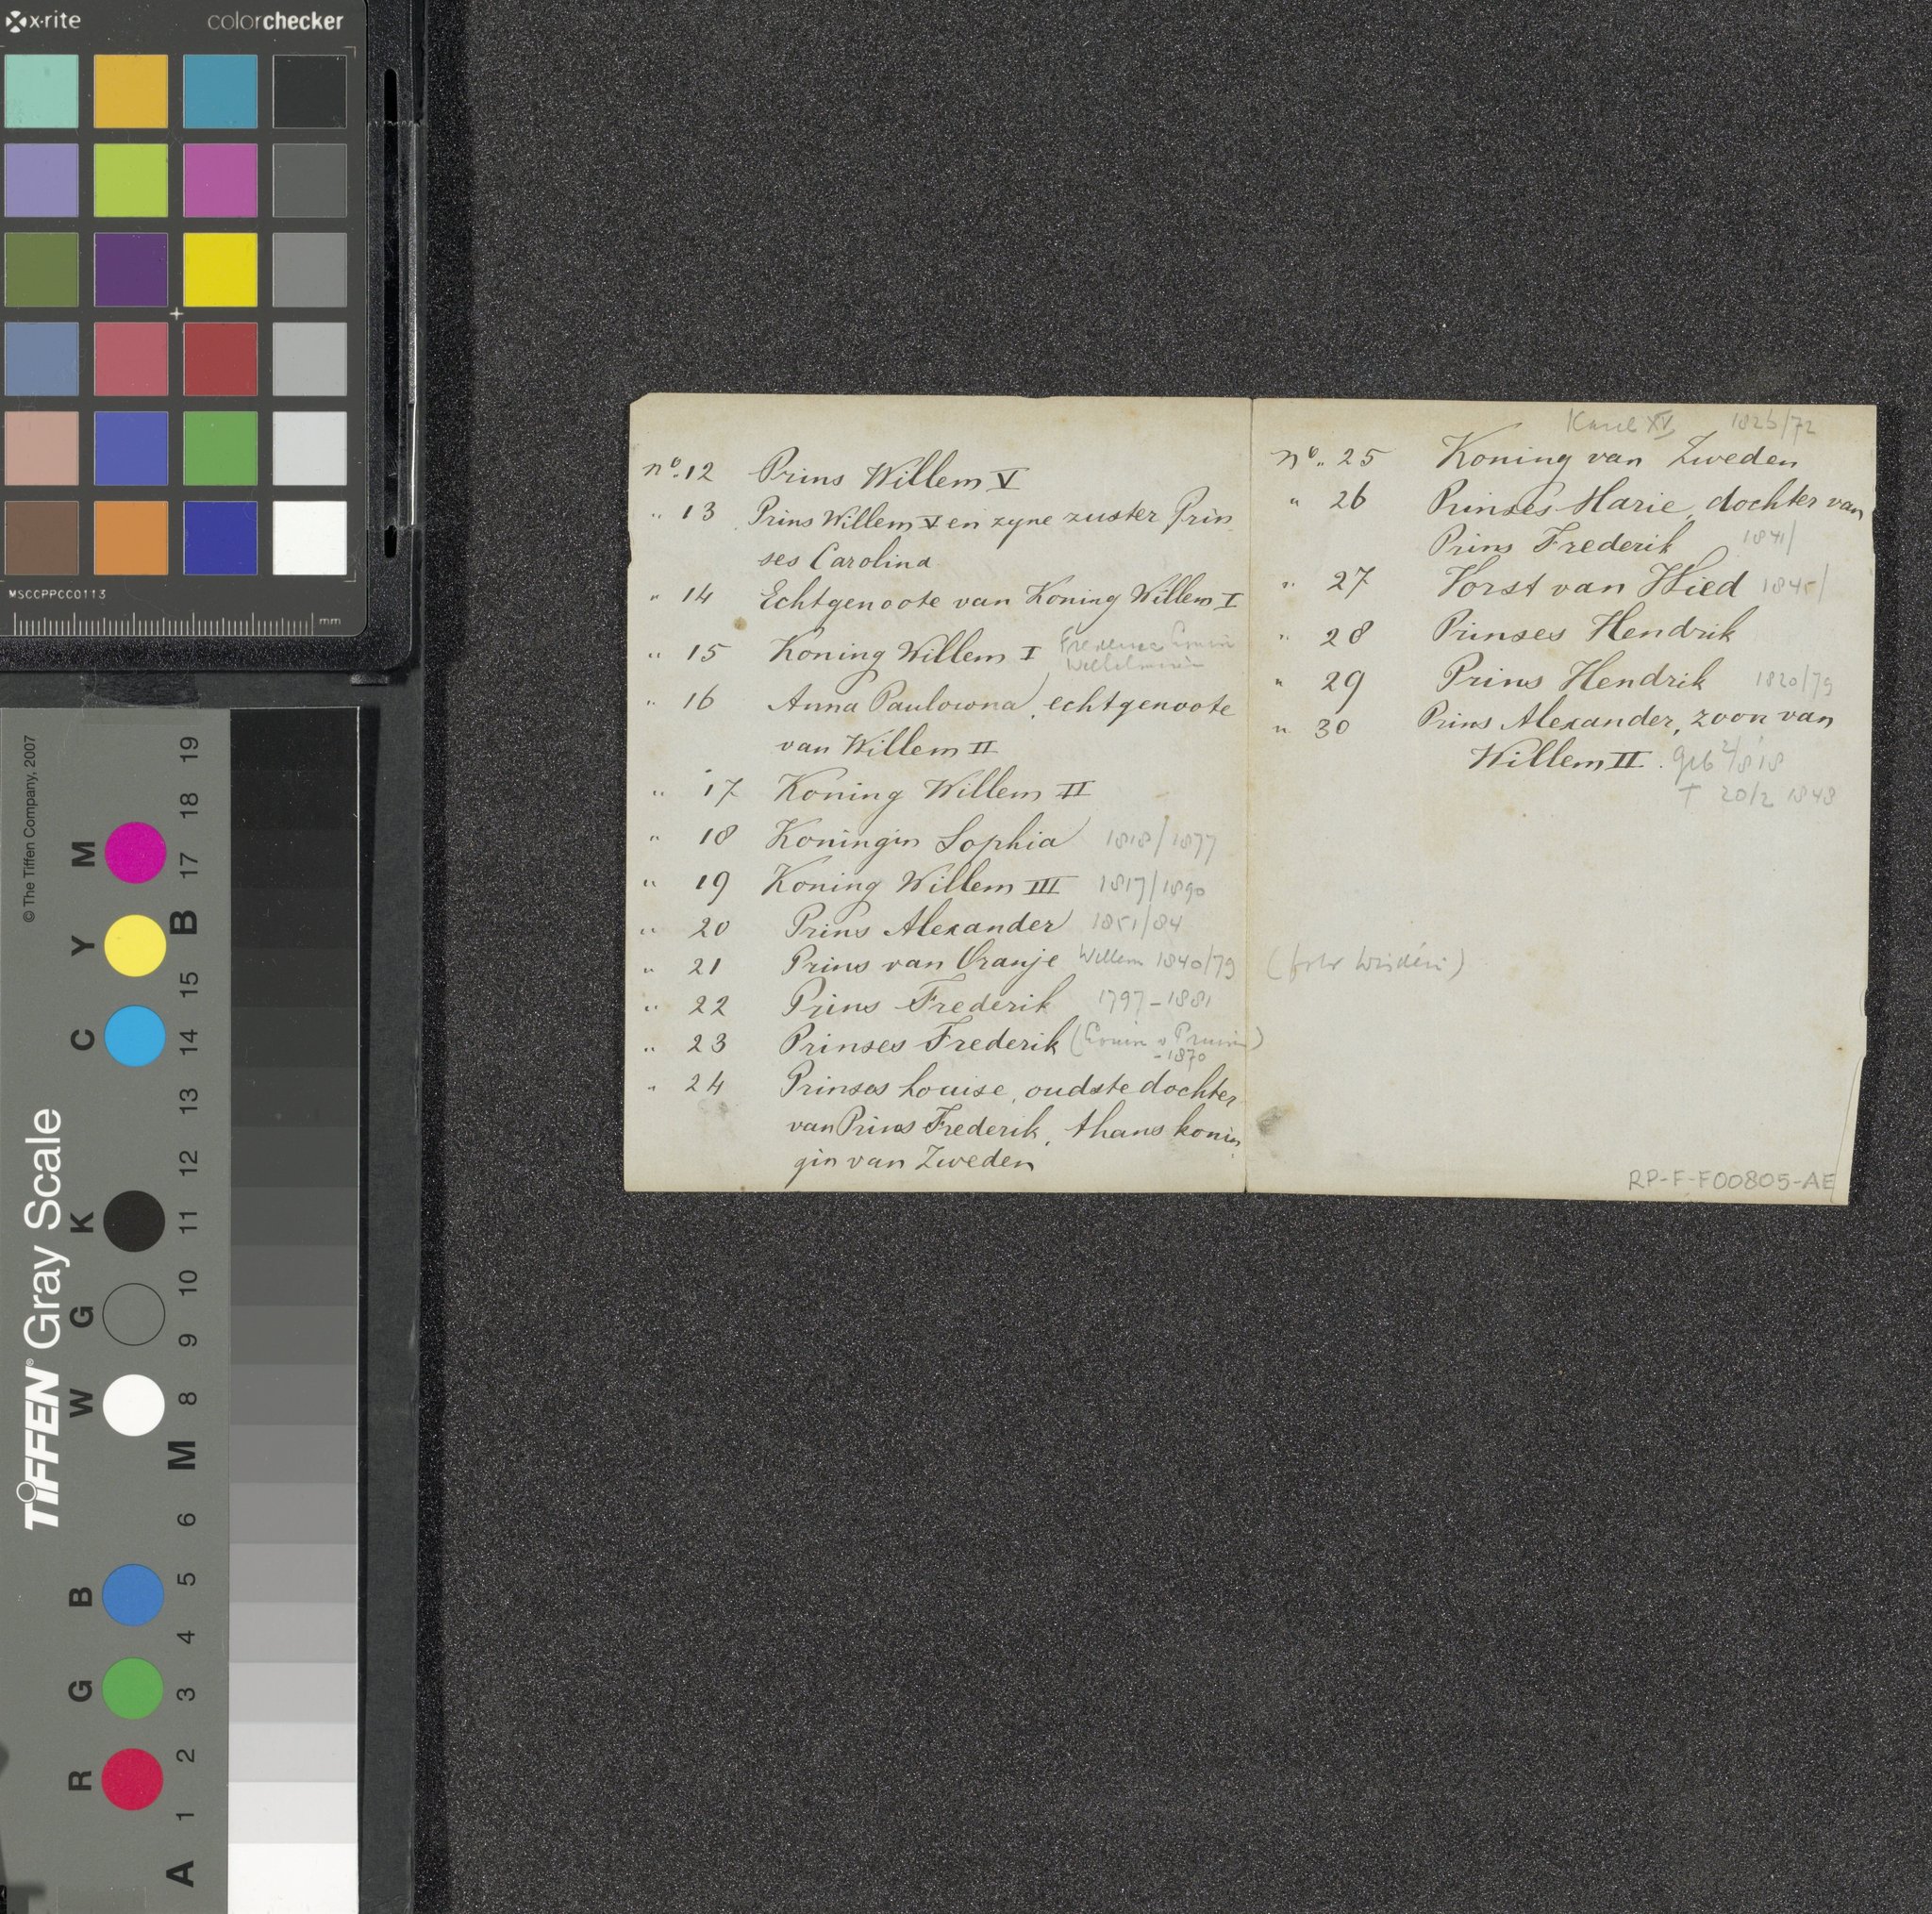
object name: list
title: Lijst met namen van in fotoalbum afgebeelde personen (nrs. 12 t/m 30)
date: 1860-1890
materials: paper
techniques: writing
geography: netherlands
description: Genummerde lijst met de namen en functies van afgebeelde personen, met de hand geschreven in zwarte inkt door een onbekende persoon. Achter de namen zijn in een ander handschrift voornamelijk jaartallen geschreven met potlood. Vermoedelijk zijn dit aanvullingen door verzamelaar L.J. Hartkamp. Onderdeel van Fotoalbum met 29 foto's van Nederlandse vorsten.